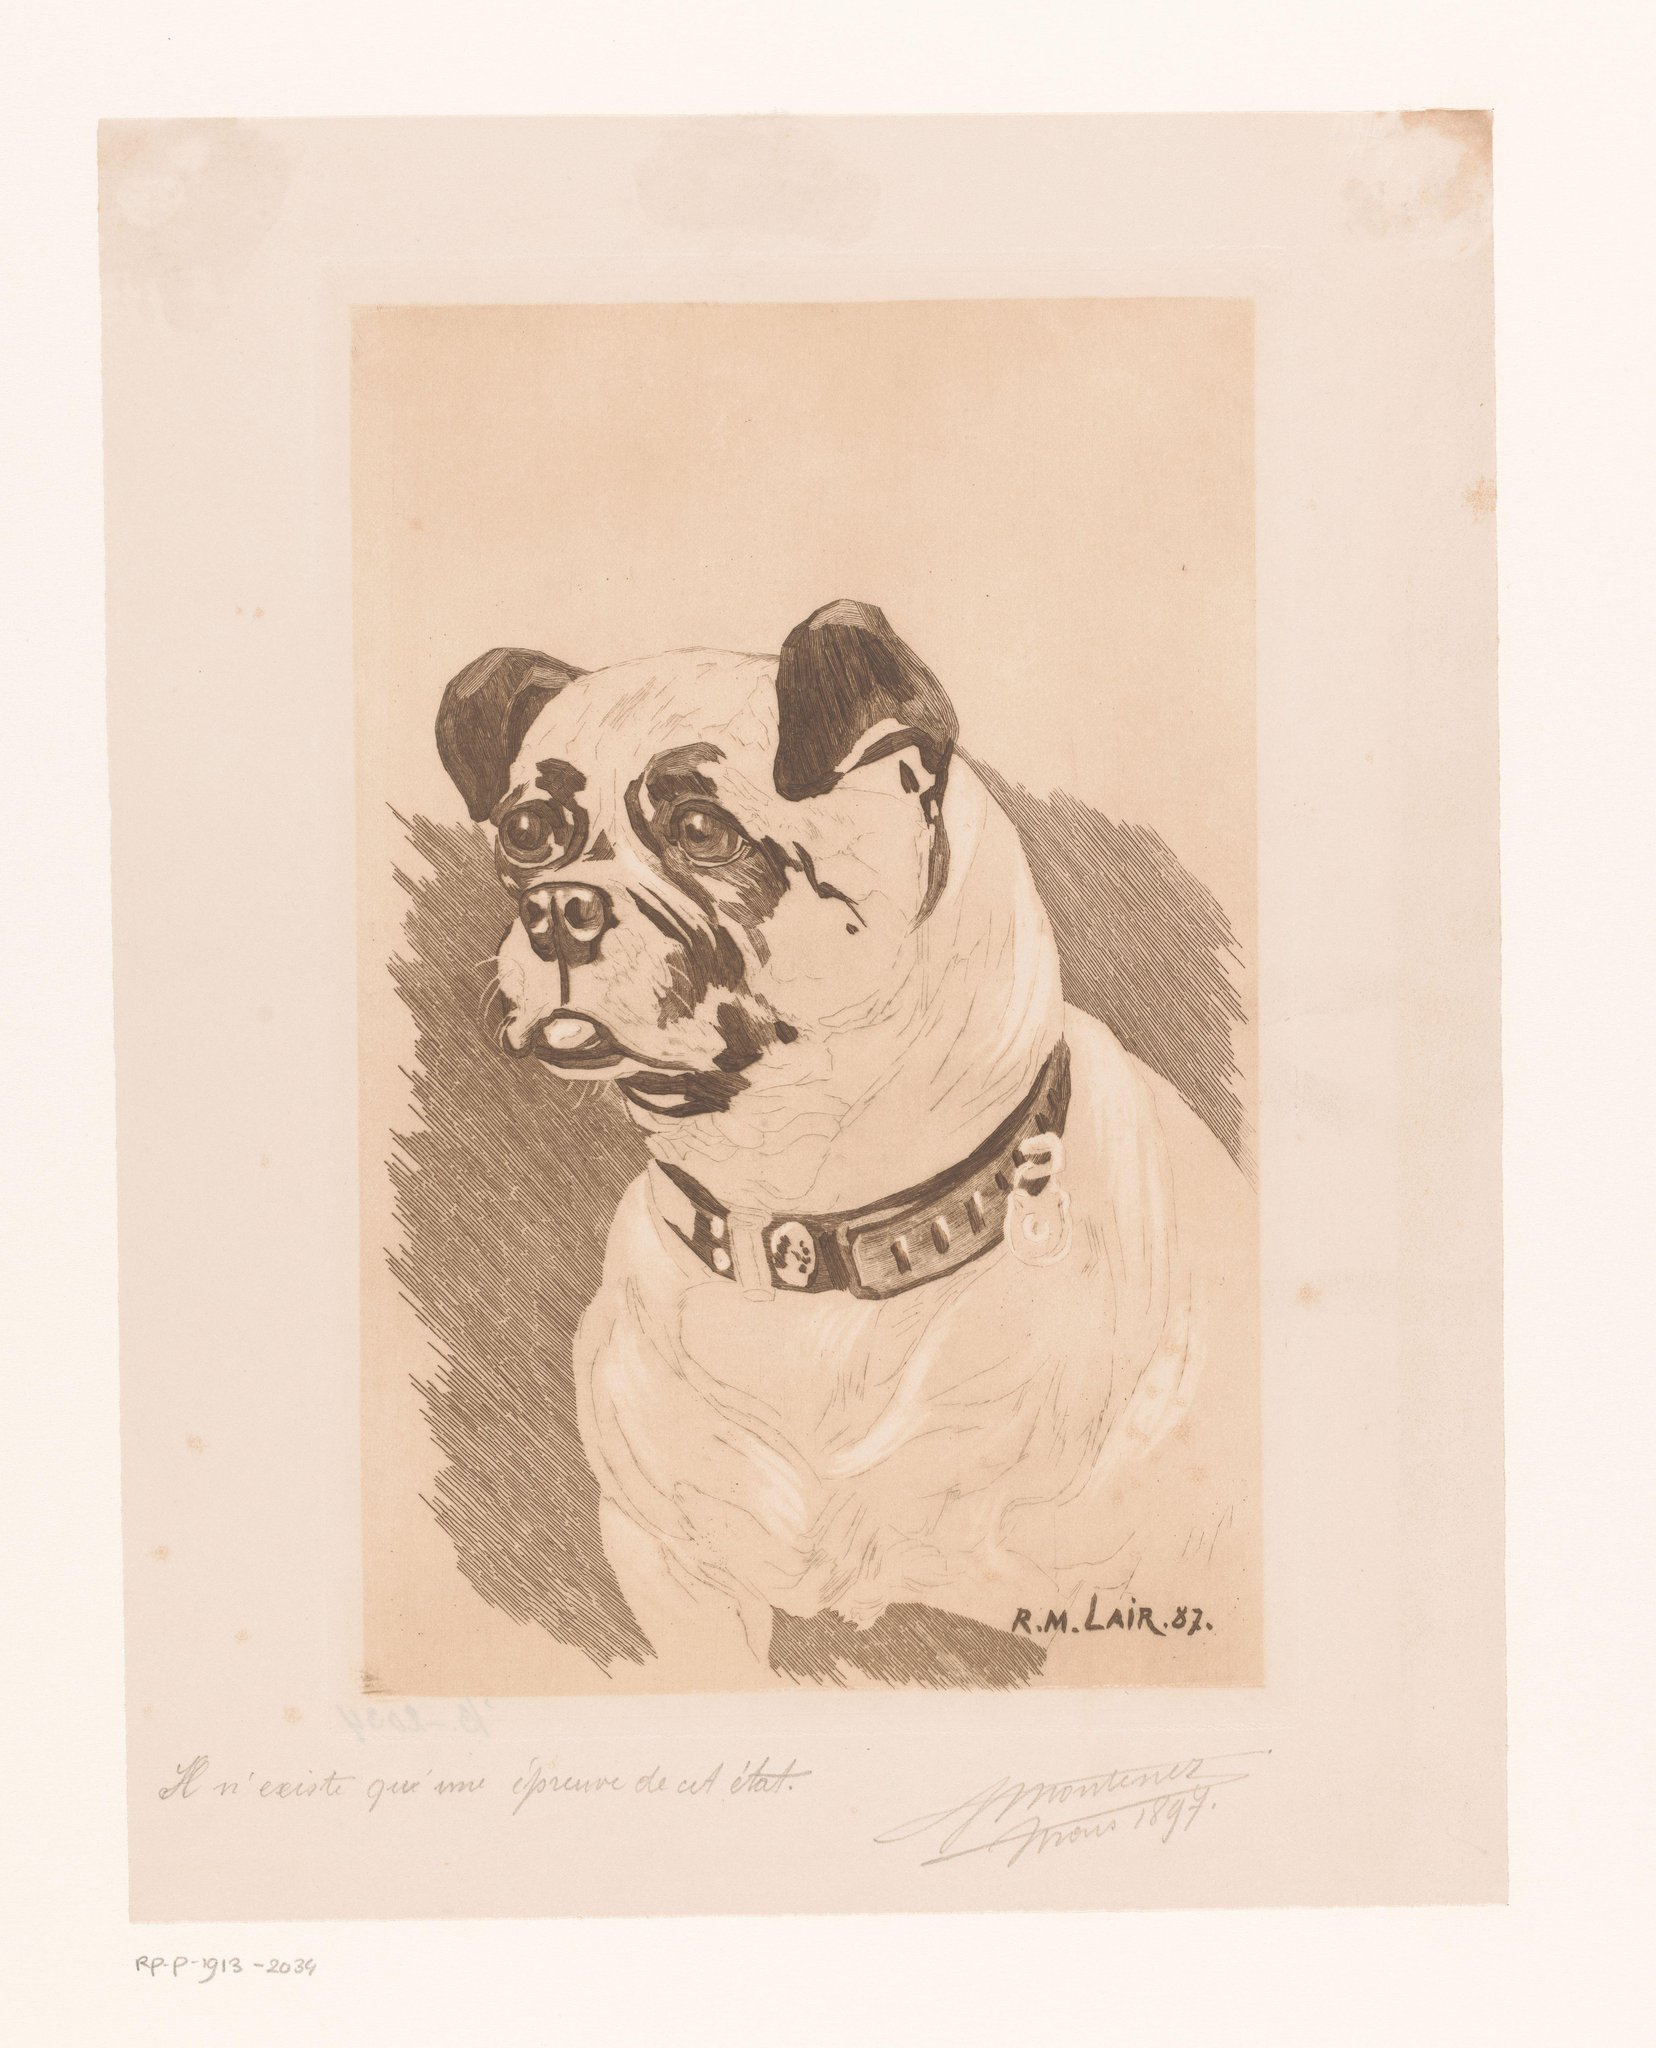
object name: print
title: Hond met halsband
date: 1897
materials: paper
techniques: etching, intaglio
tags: collar (of a dog), dog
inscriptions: inscription: ‘El n'existe qui une épreuve de cit état; Mons 1897’, collector's mark: Lugt 2228